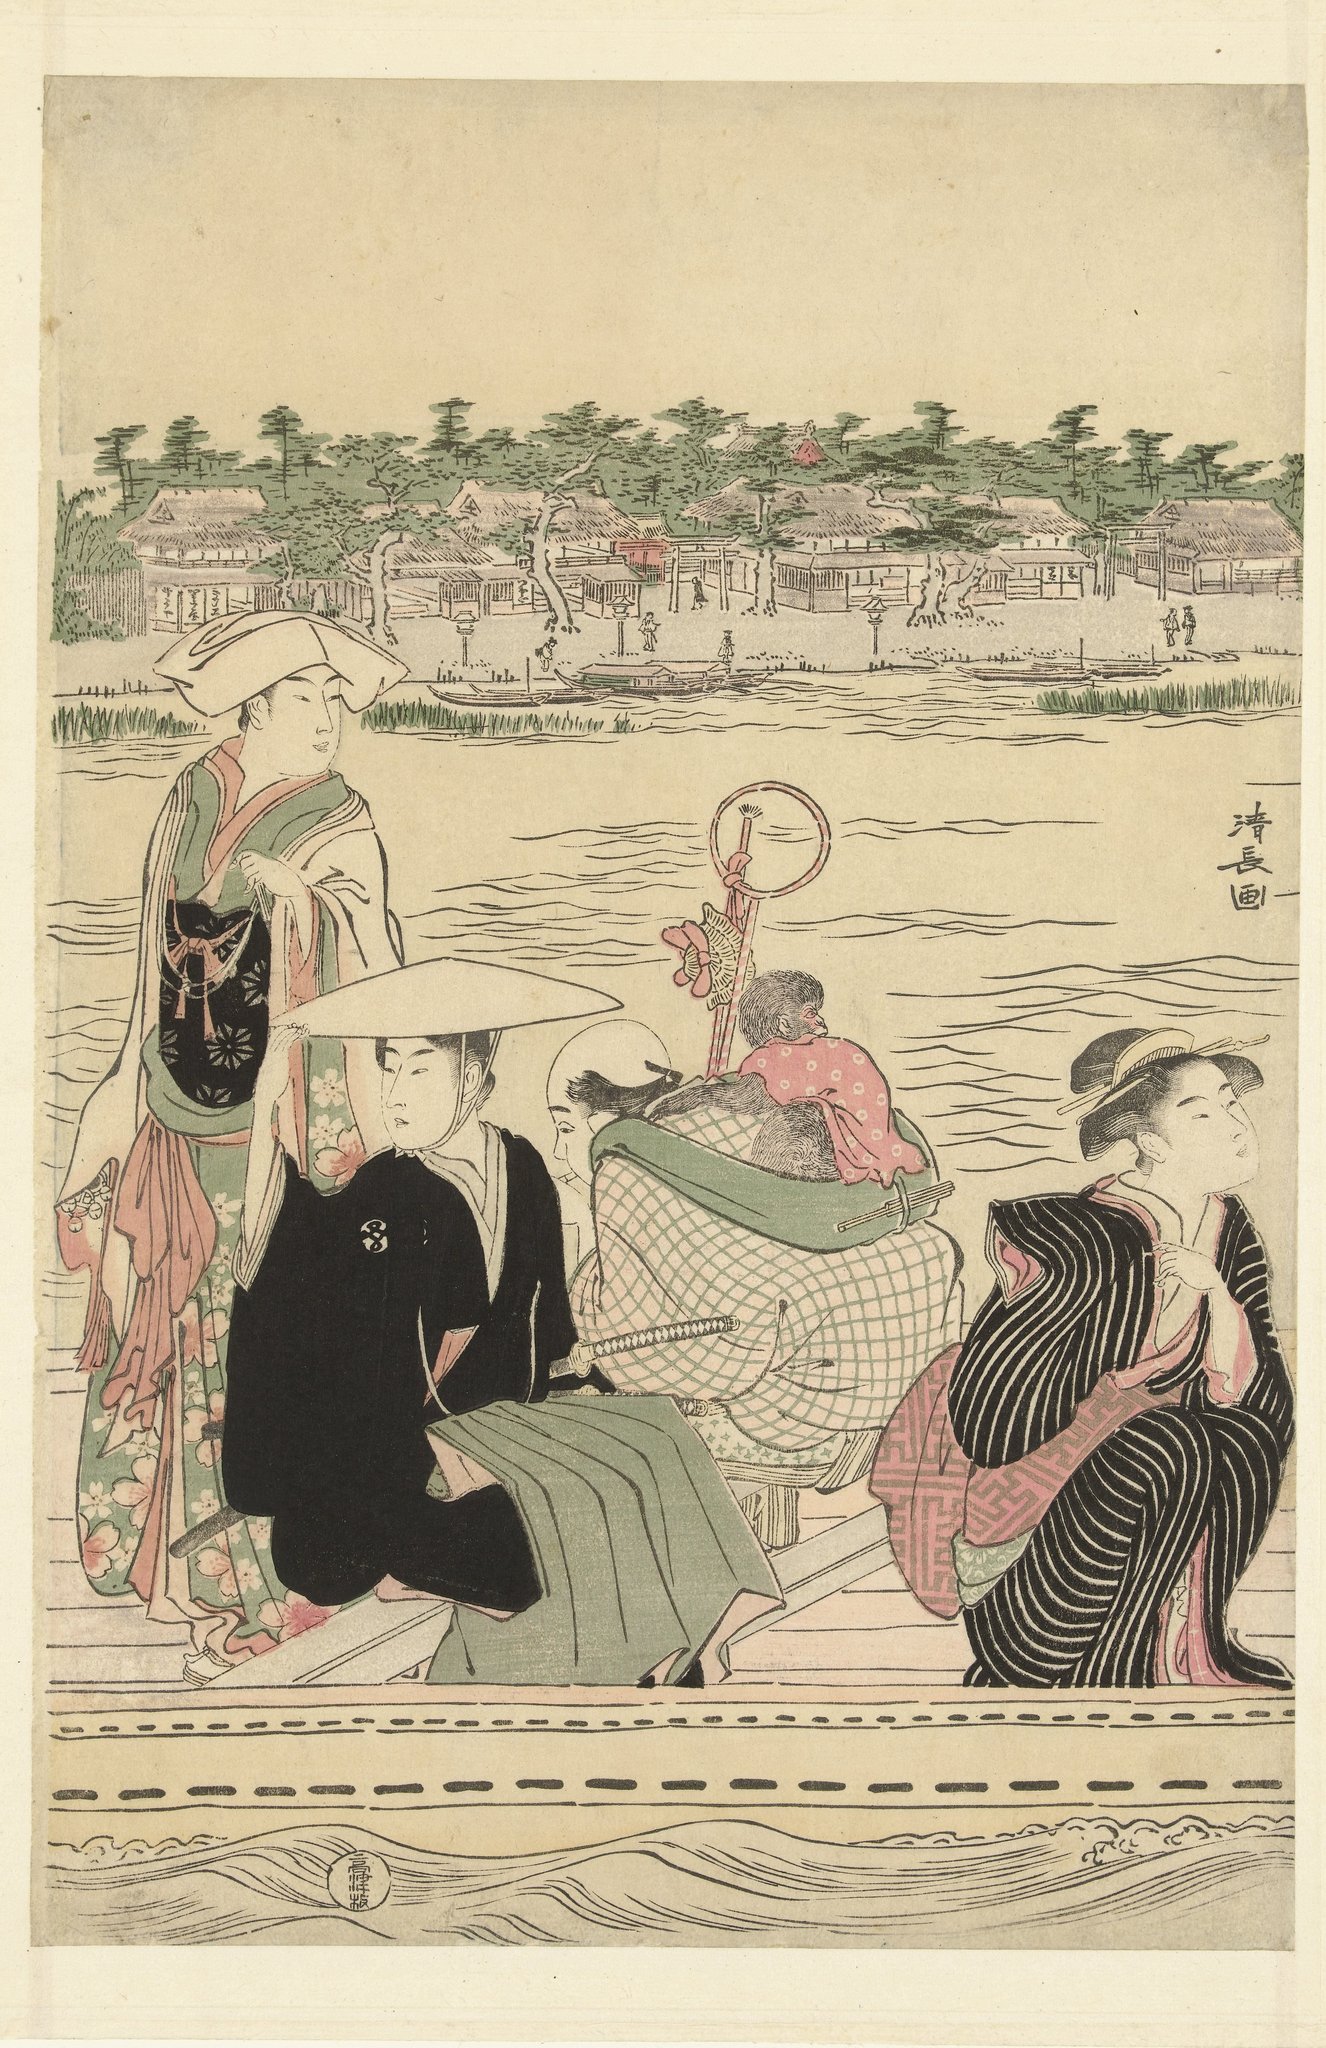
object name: print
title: Veerboot op de rivier de Sumida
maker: torii kiyonaga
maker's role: draughtsman, print maker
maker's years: 1752-1815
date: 1785-1789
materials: paper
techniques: woodcut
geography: japan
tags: river, passengers ~ ship, rowing-boat, canoe, etc.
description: Veerboot waarin, staand, vrouwelijke tempelbediende, zittend, samoerai met reishoed waarnaast man met aap, en hurkend, vrouw in zwart-wit gestreepte kimono; op de achtergrond theehuizen op de oever van de Sumida.